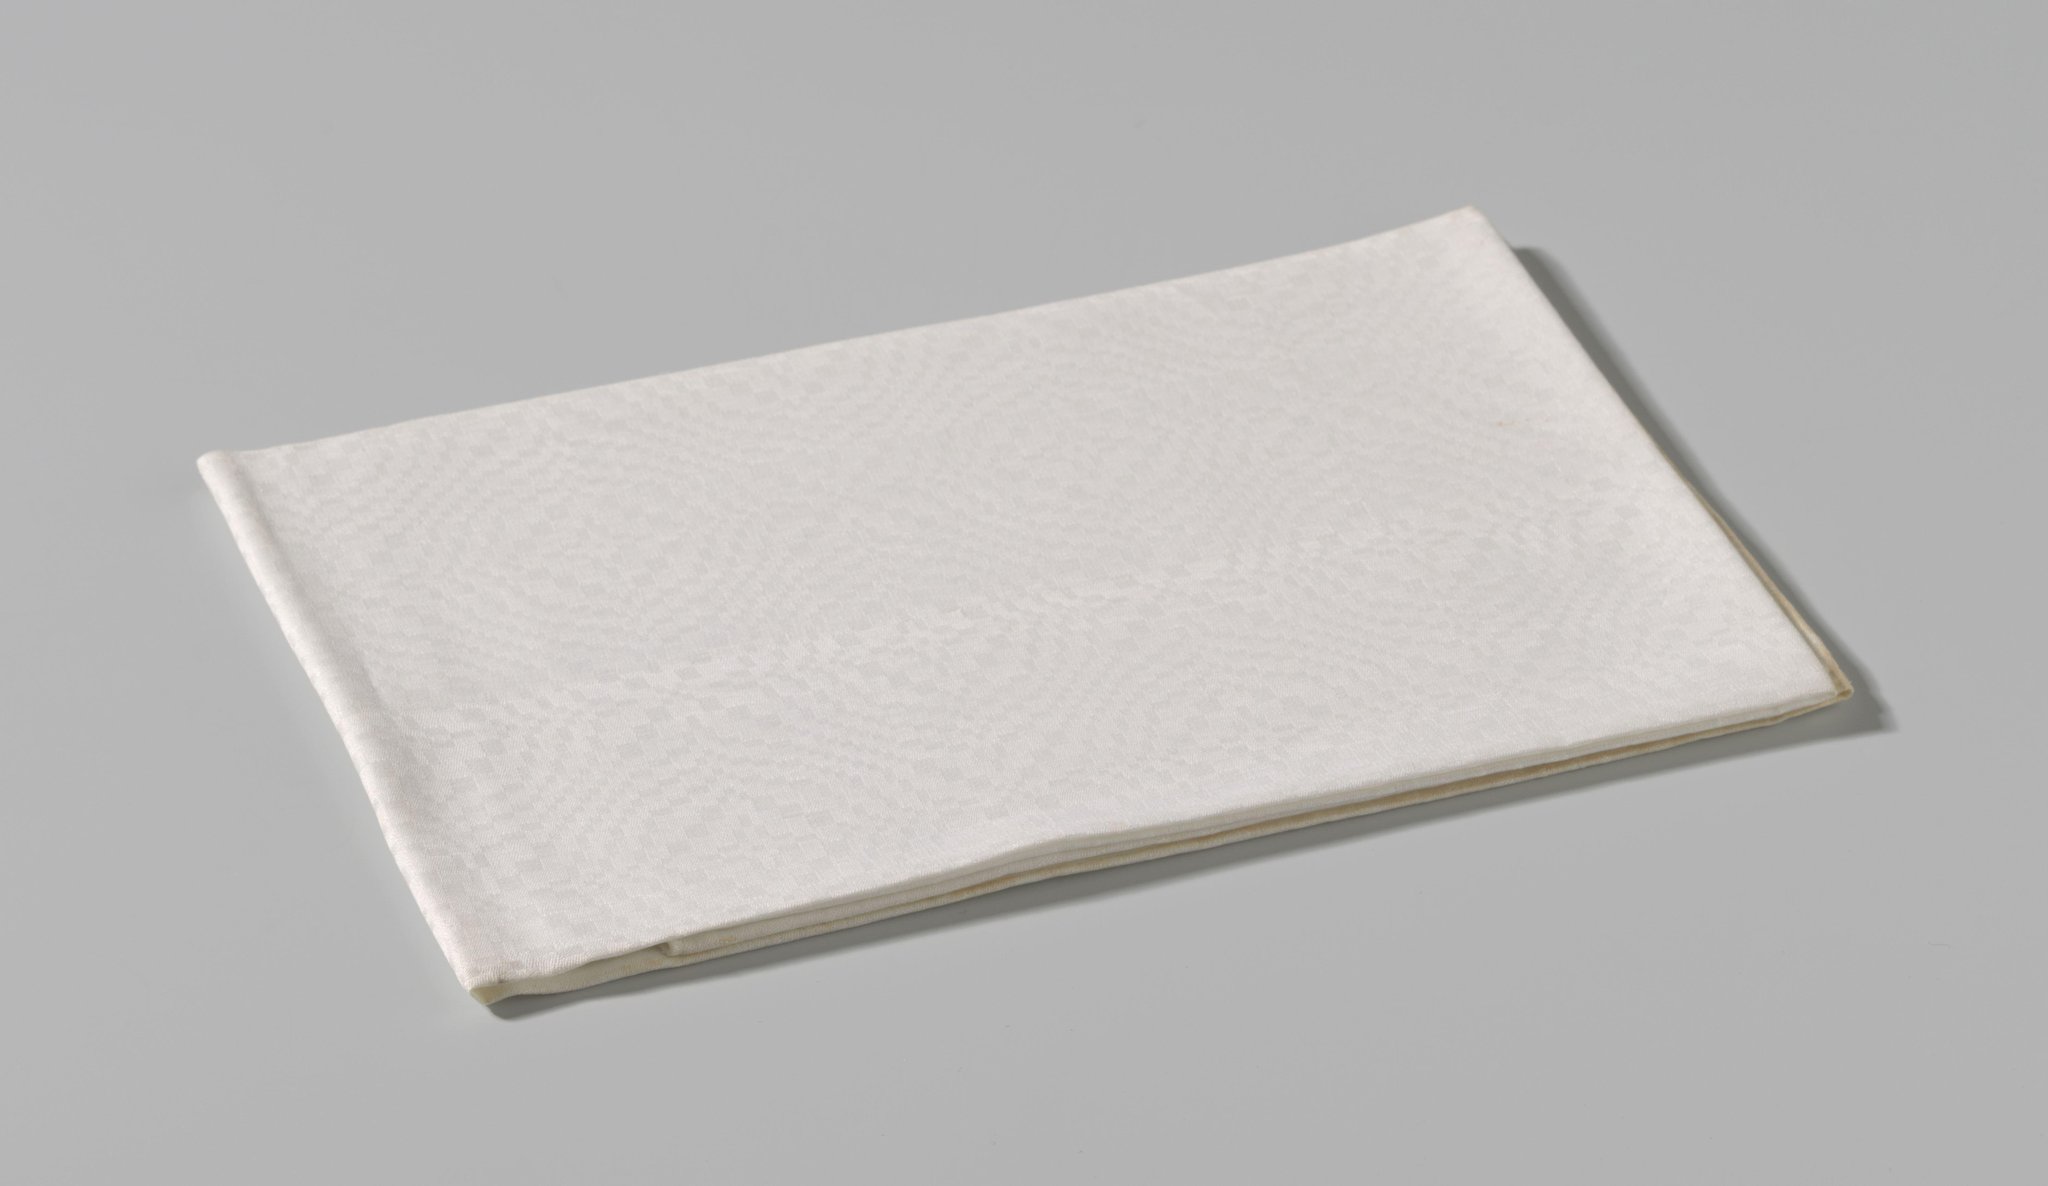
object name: napkin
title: Pellenpatroon, z.g. 'fijne molenwiek'. Merk: CH 42.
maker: Anonymous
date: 1600-1699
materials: linen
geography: northern netherlands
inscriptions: mark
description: Servet van wit linnen met een pellen patroon z.g. 'fijne molenwiek', merk CH 42.